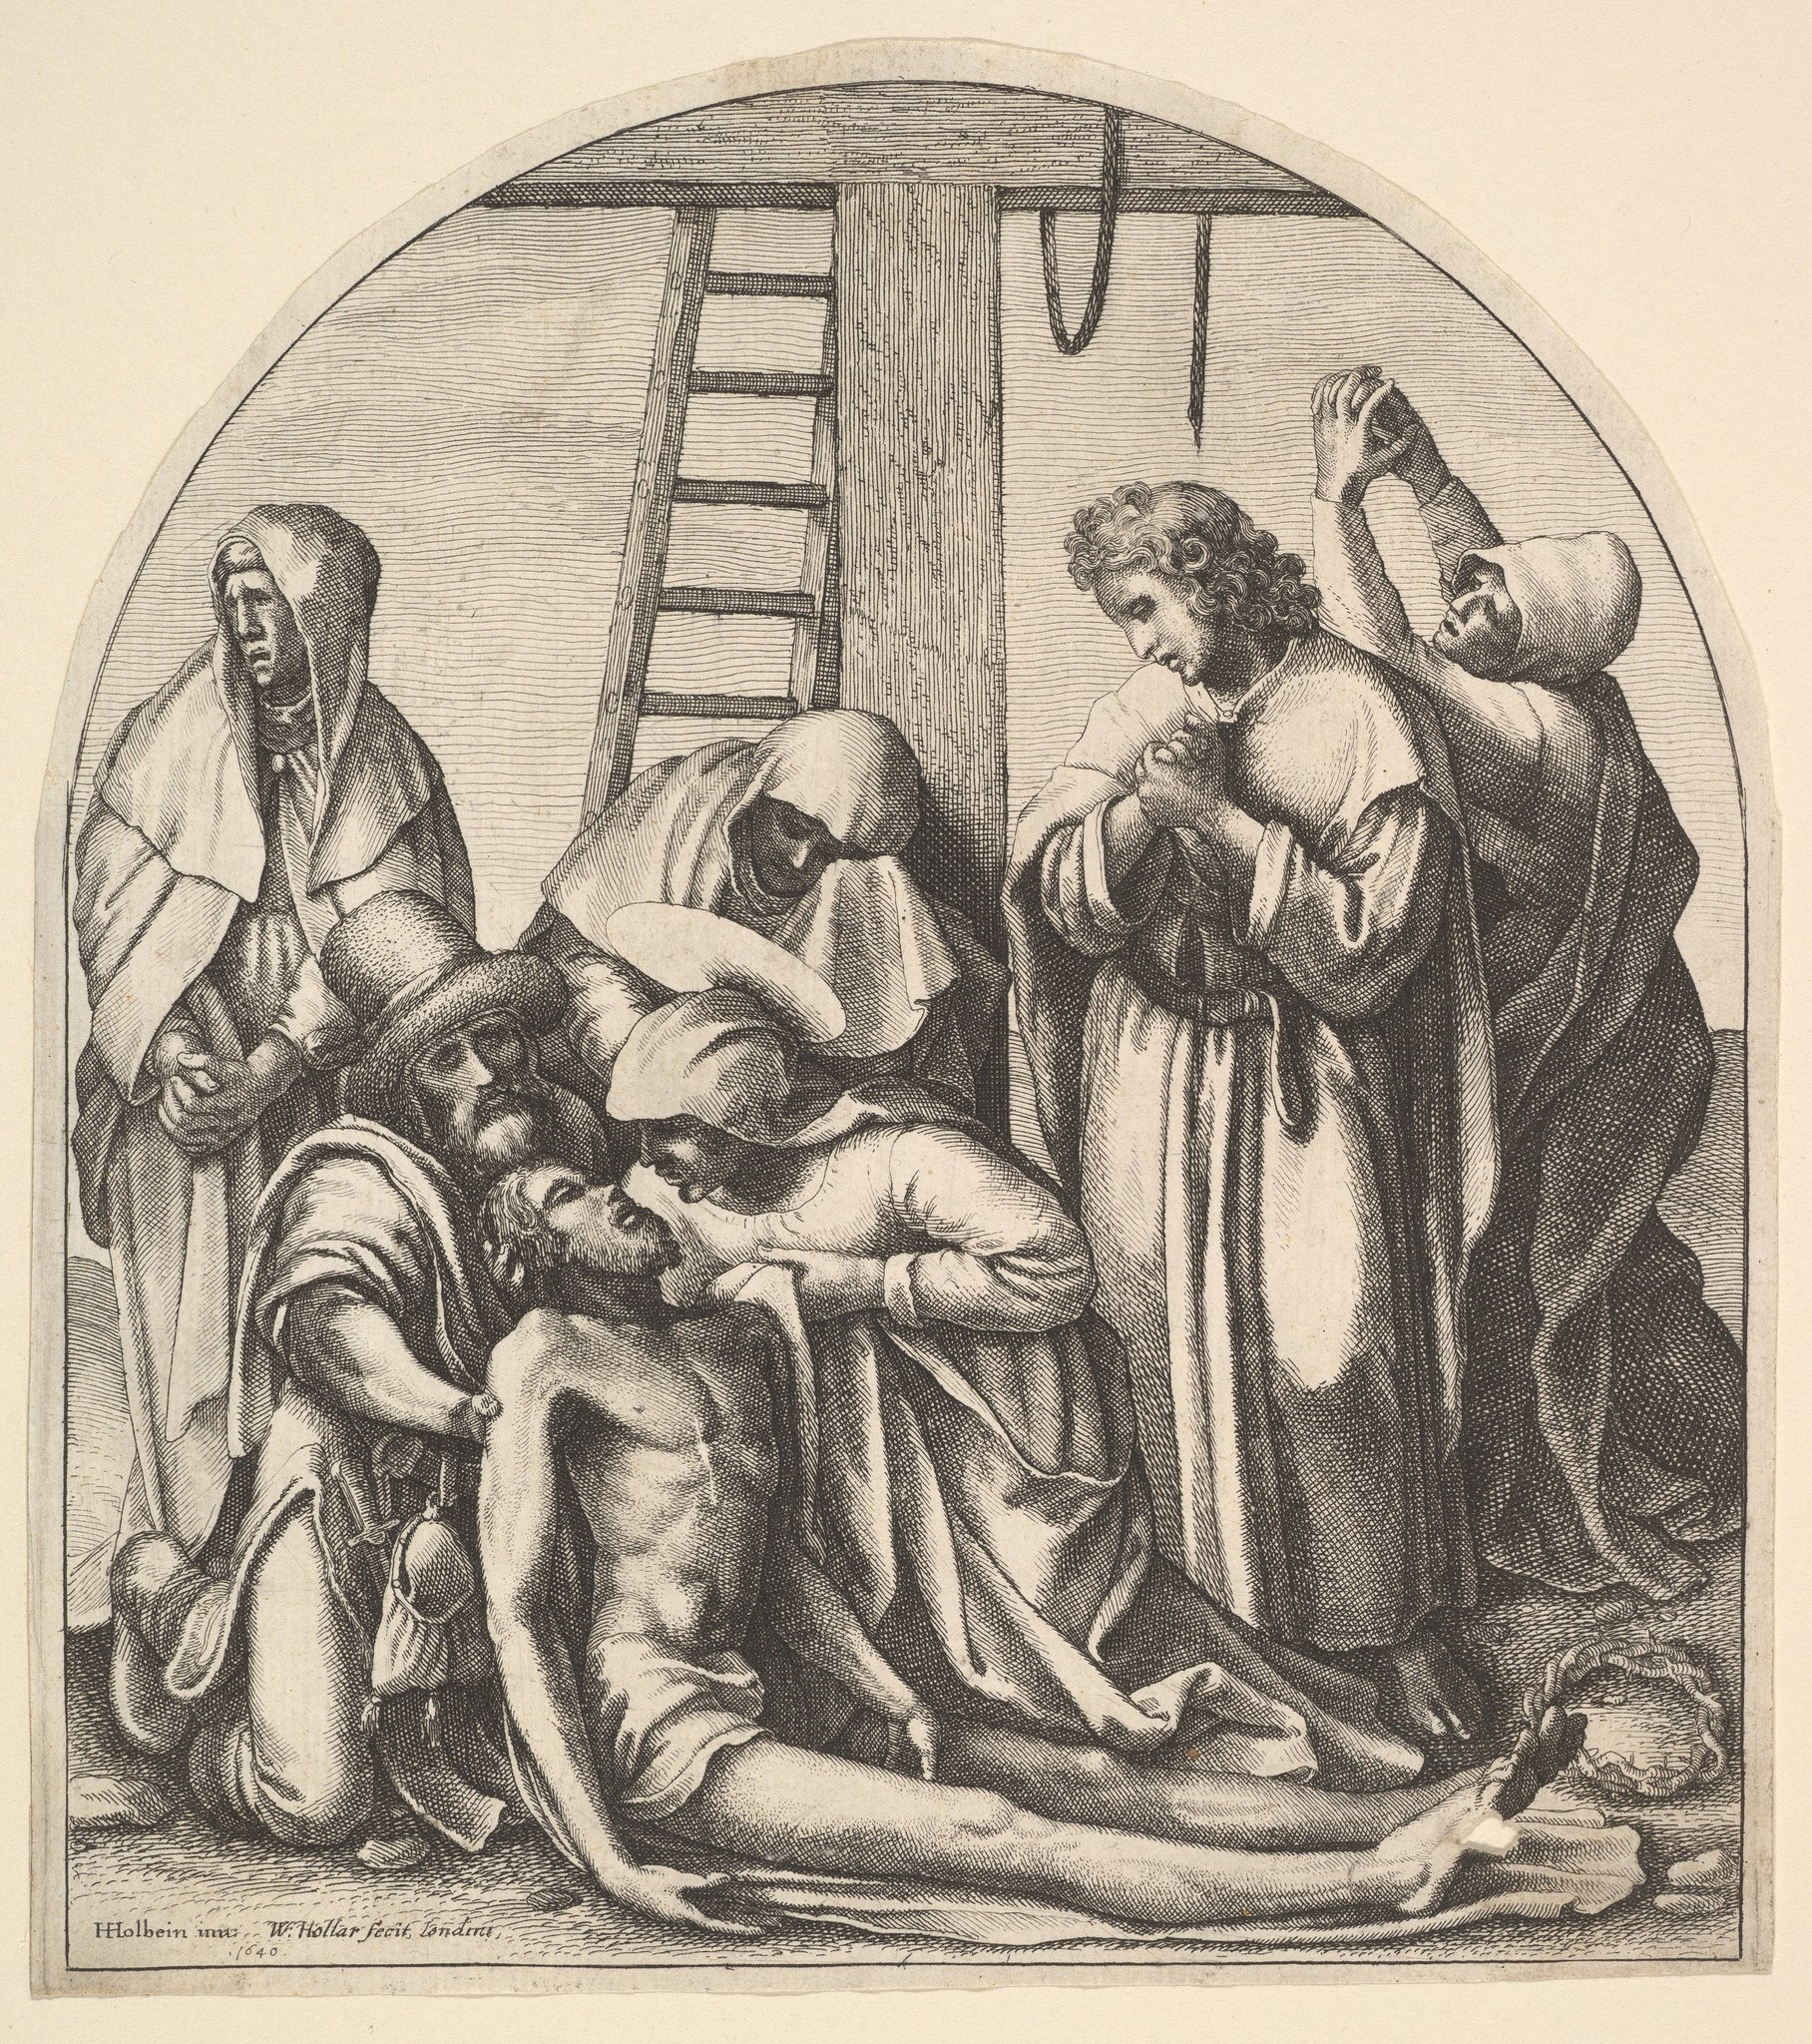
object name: print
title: Descent from the Cross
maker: wenceslaus hollar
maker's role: artist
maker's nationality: bohemian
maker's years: 1607-1677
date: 1640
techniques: etching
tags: women,christ,virgin mary,cross,ladders